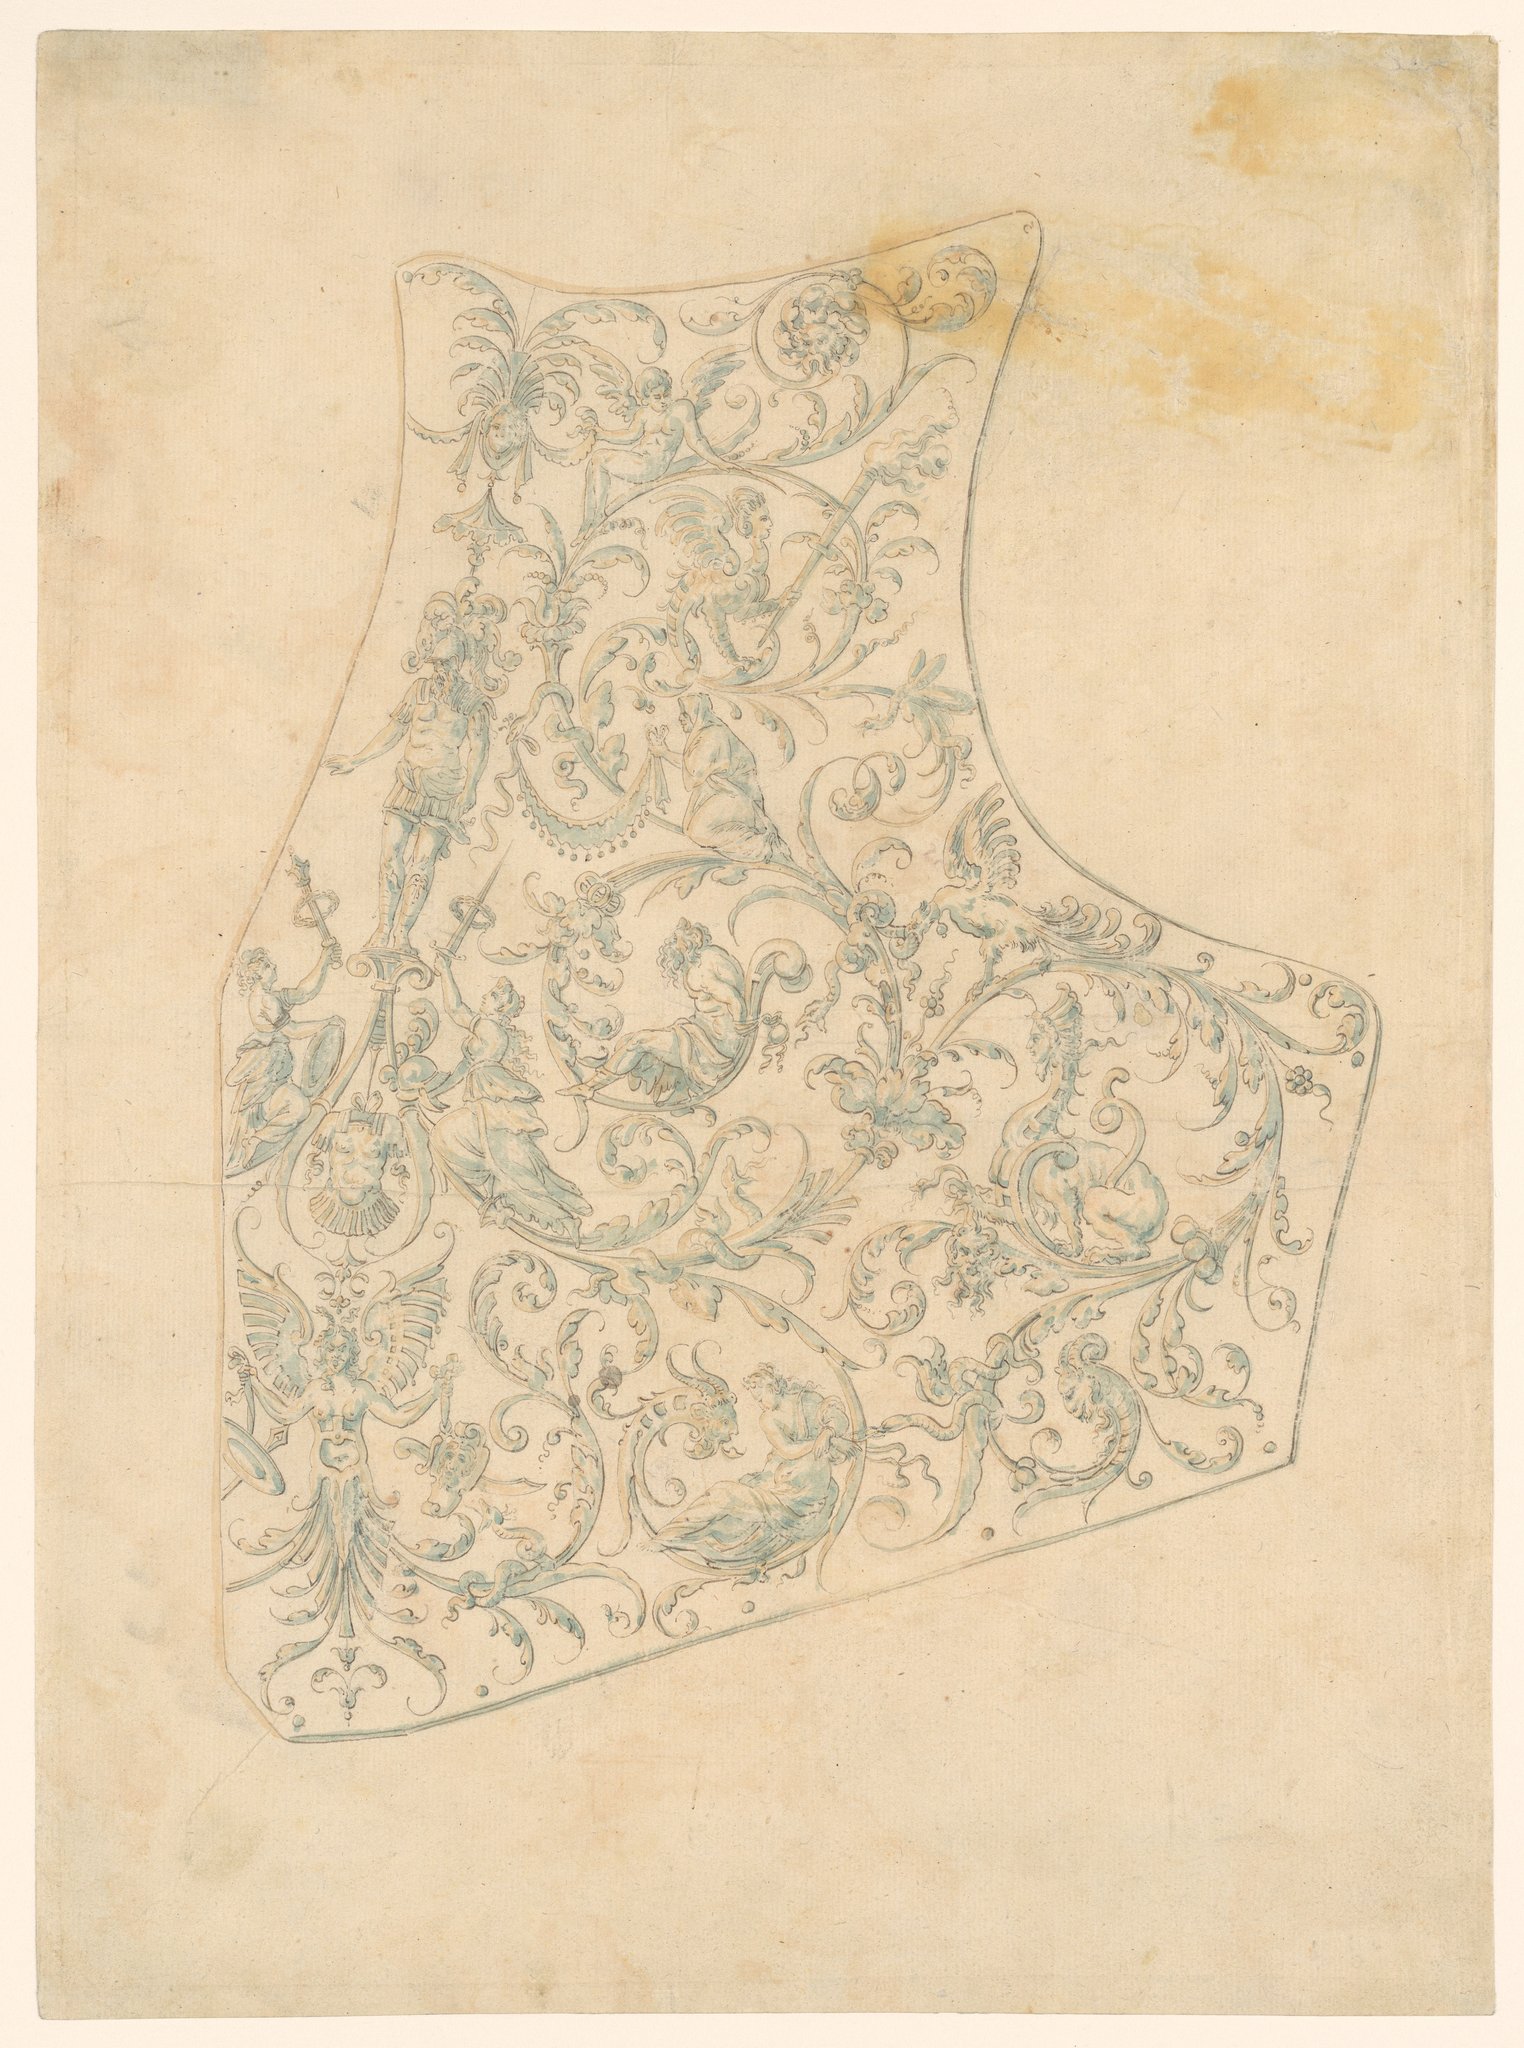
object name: drawing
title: Design for the Breastplate of a Suit of Armor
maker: etienne delaune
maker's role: artist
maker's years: 1501-1599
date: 1576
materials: ink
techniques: pen, wash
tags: armor,ornament